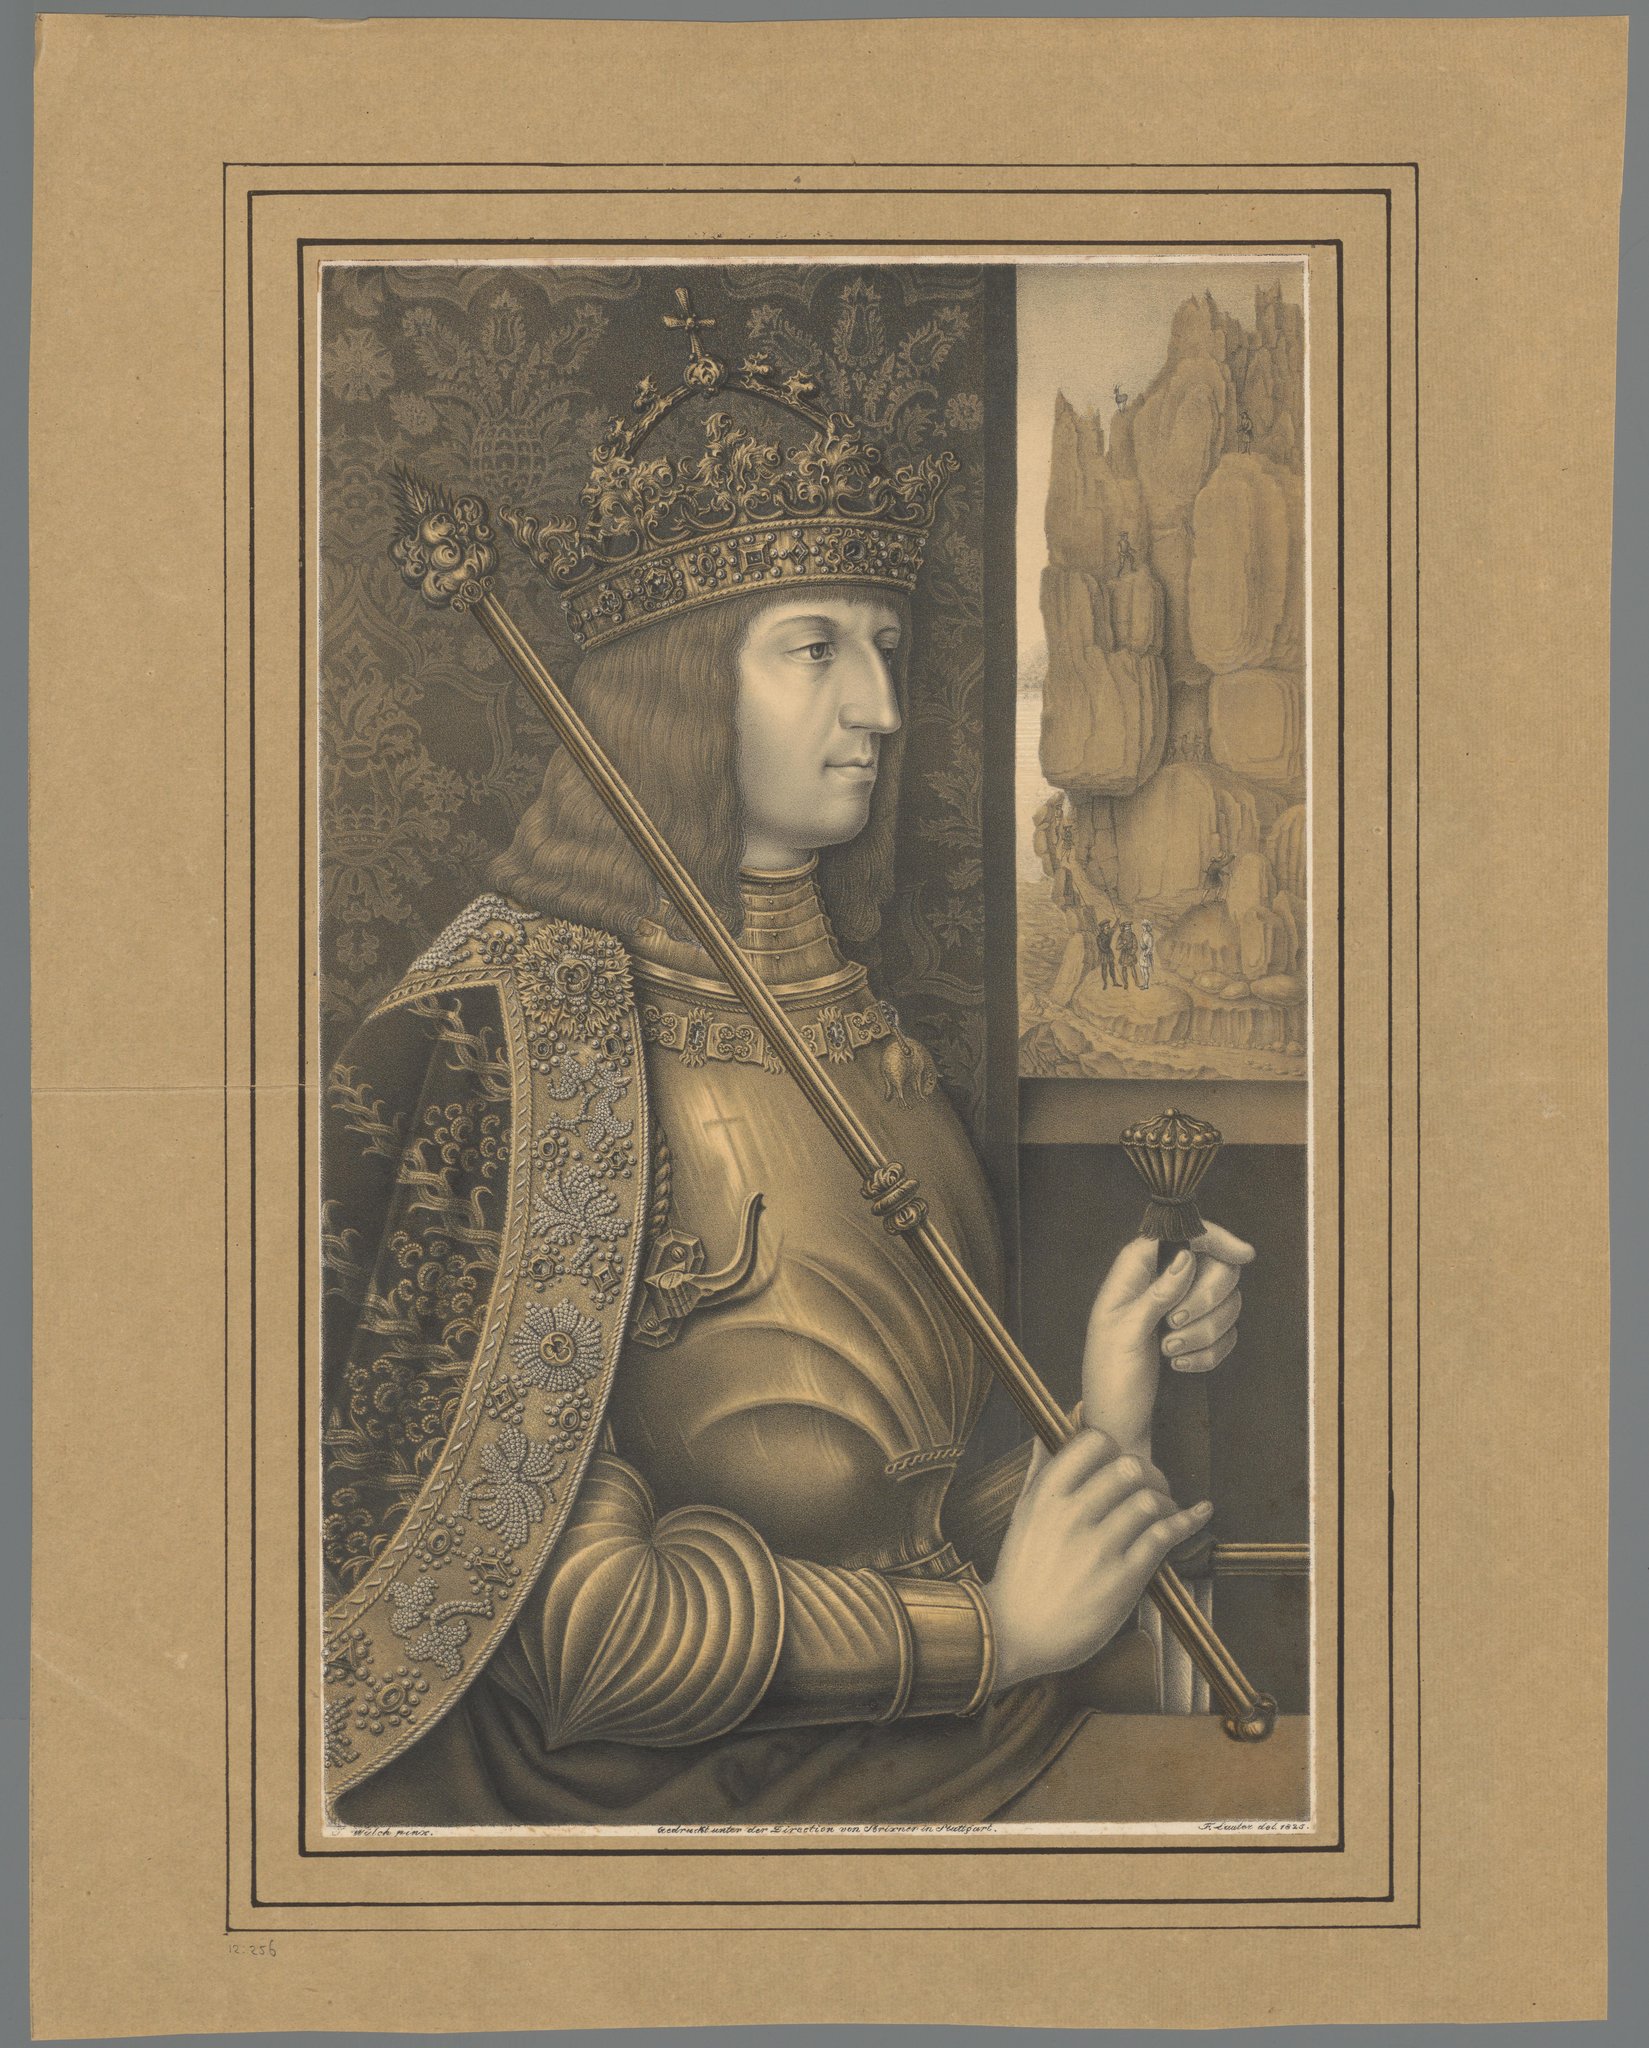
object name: print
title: Werken uit de collectie van de broers Boisserée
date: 1825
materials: paper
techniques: tone lithography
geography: stuttgart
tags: maximilian i (holy roman emperor), historical persons, emperor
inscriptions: collector's mark: Lugt 2228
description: Deze prent behoort tot de serie 'Galerie des Frères Boisserée'. De serie is in 38 delen uitgegeven met drie prenten per deel en nog drie extra inleidende prenten.